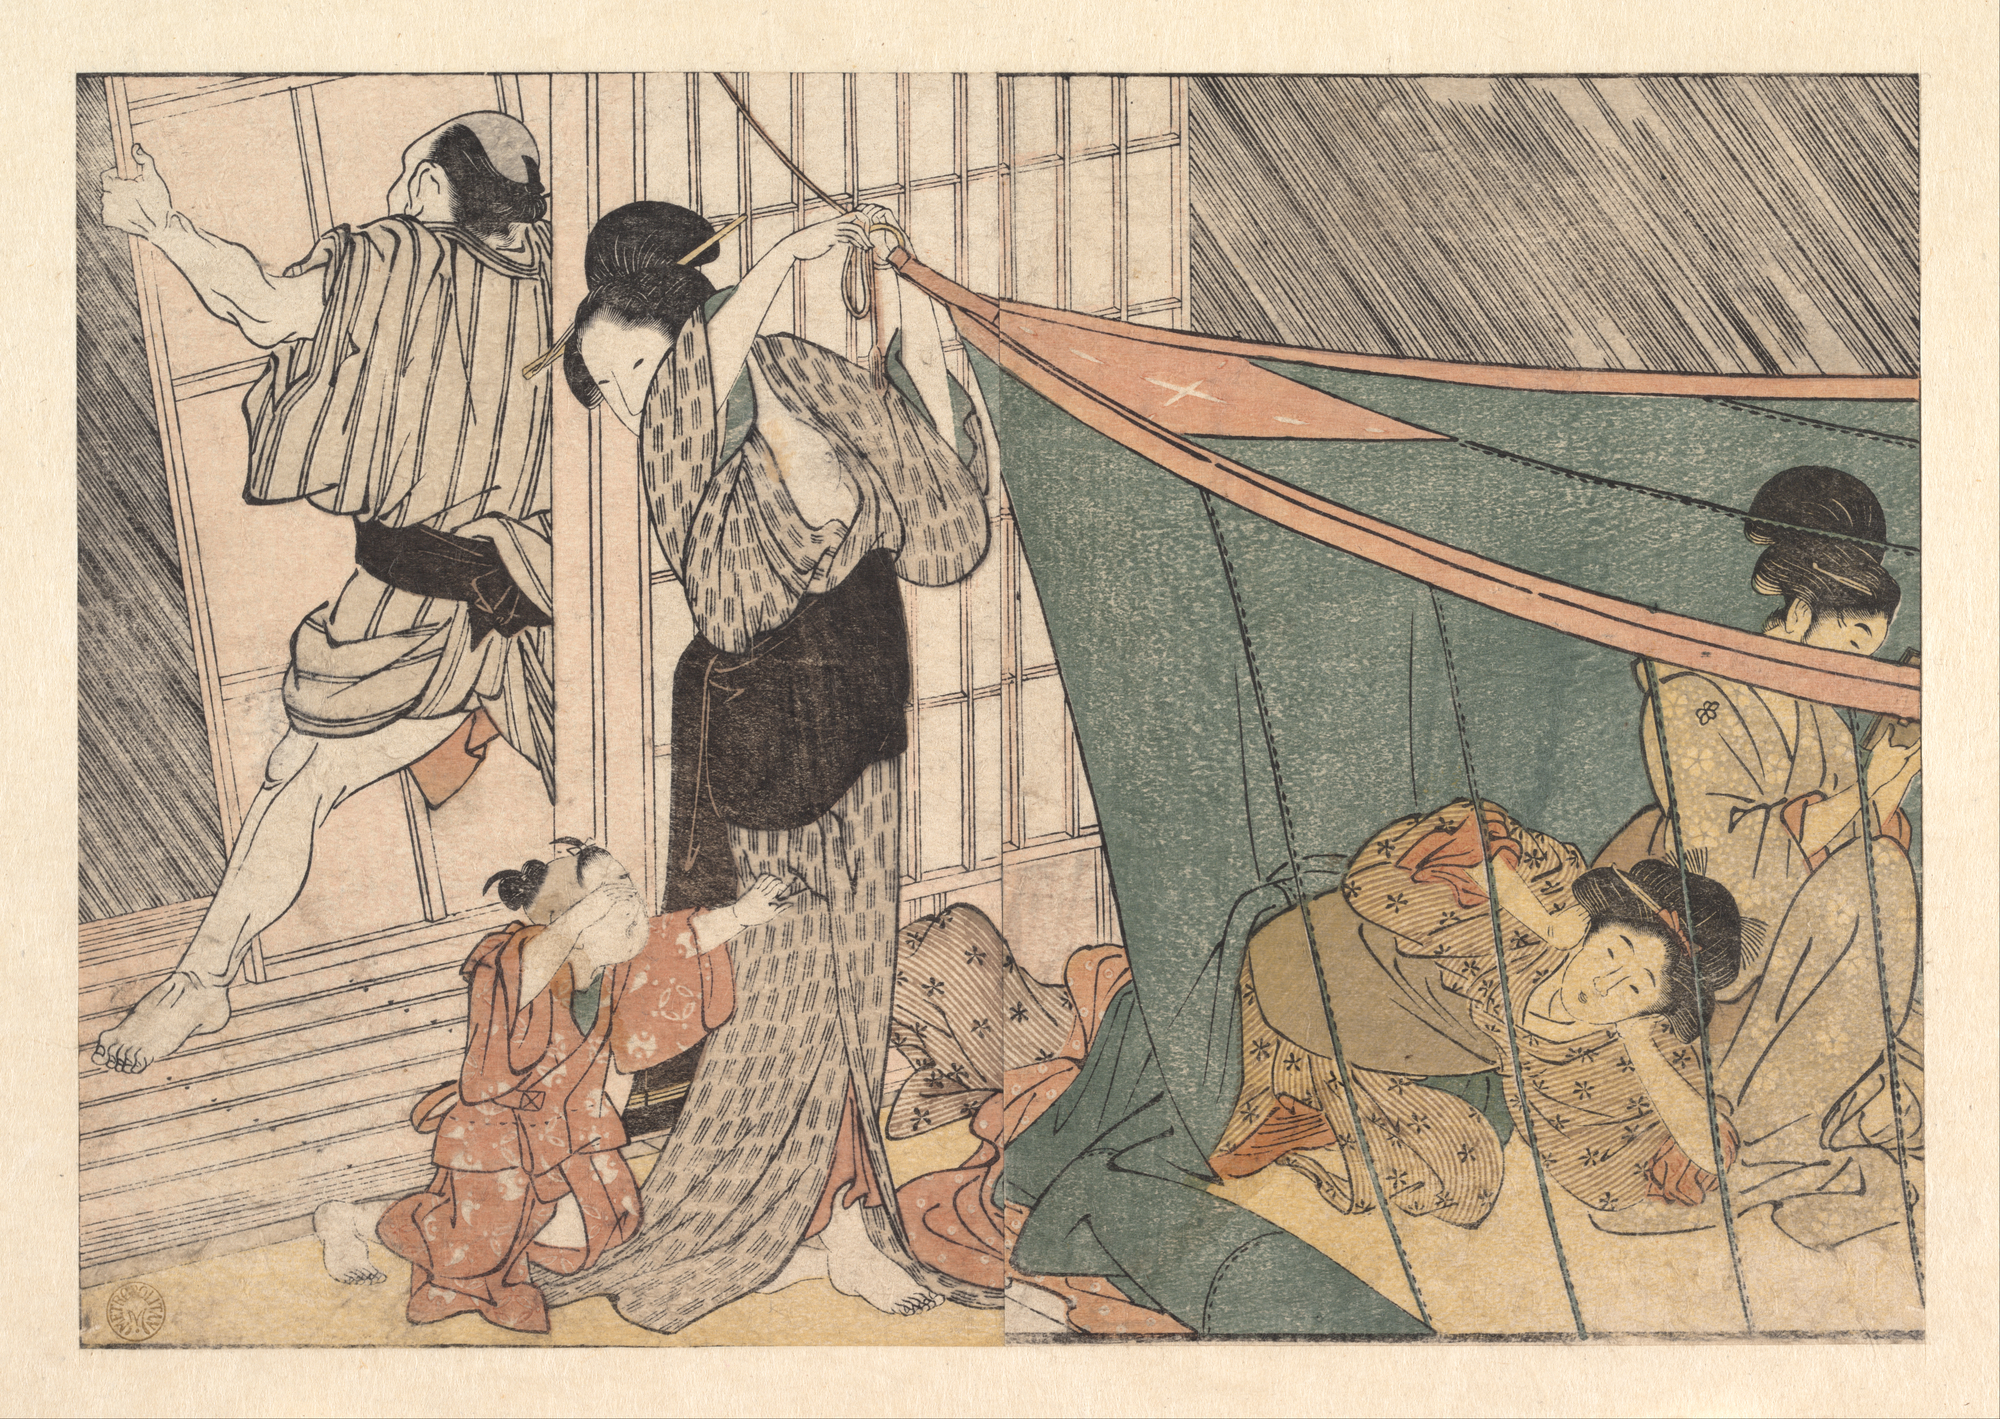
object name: woodblock print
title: The Coming Thunderstorm, from the illustrated book Flowers of the Four Seasons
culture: japanese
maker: kitagawa utamaro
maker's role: artist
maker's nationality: japanese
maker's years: 1754-1806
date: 1801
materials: ink, paper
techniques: woodblock print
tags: girls,men,women,rain